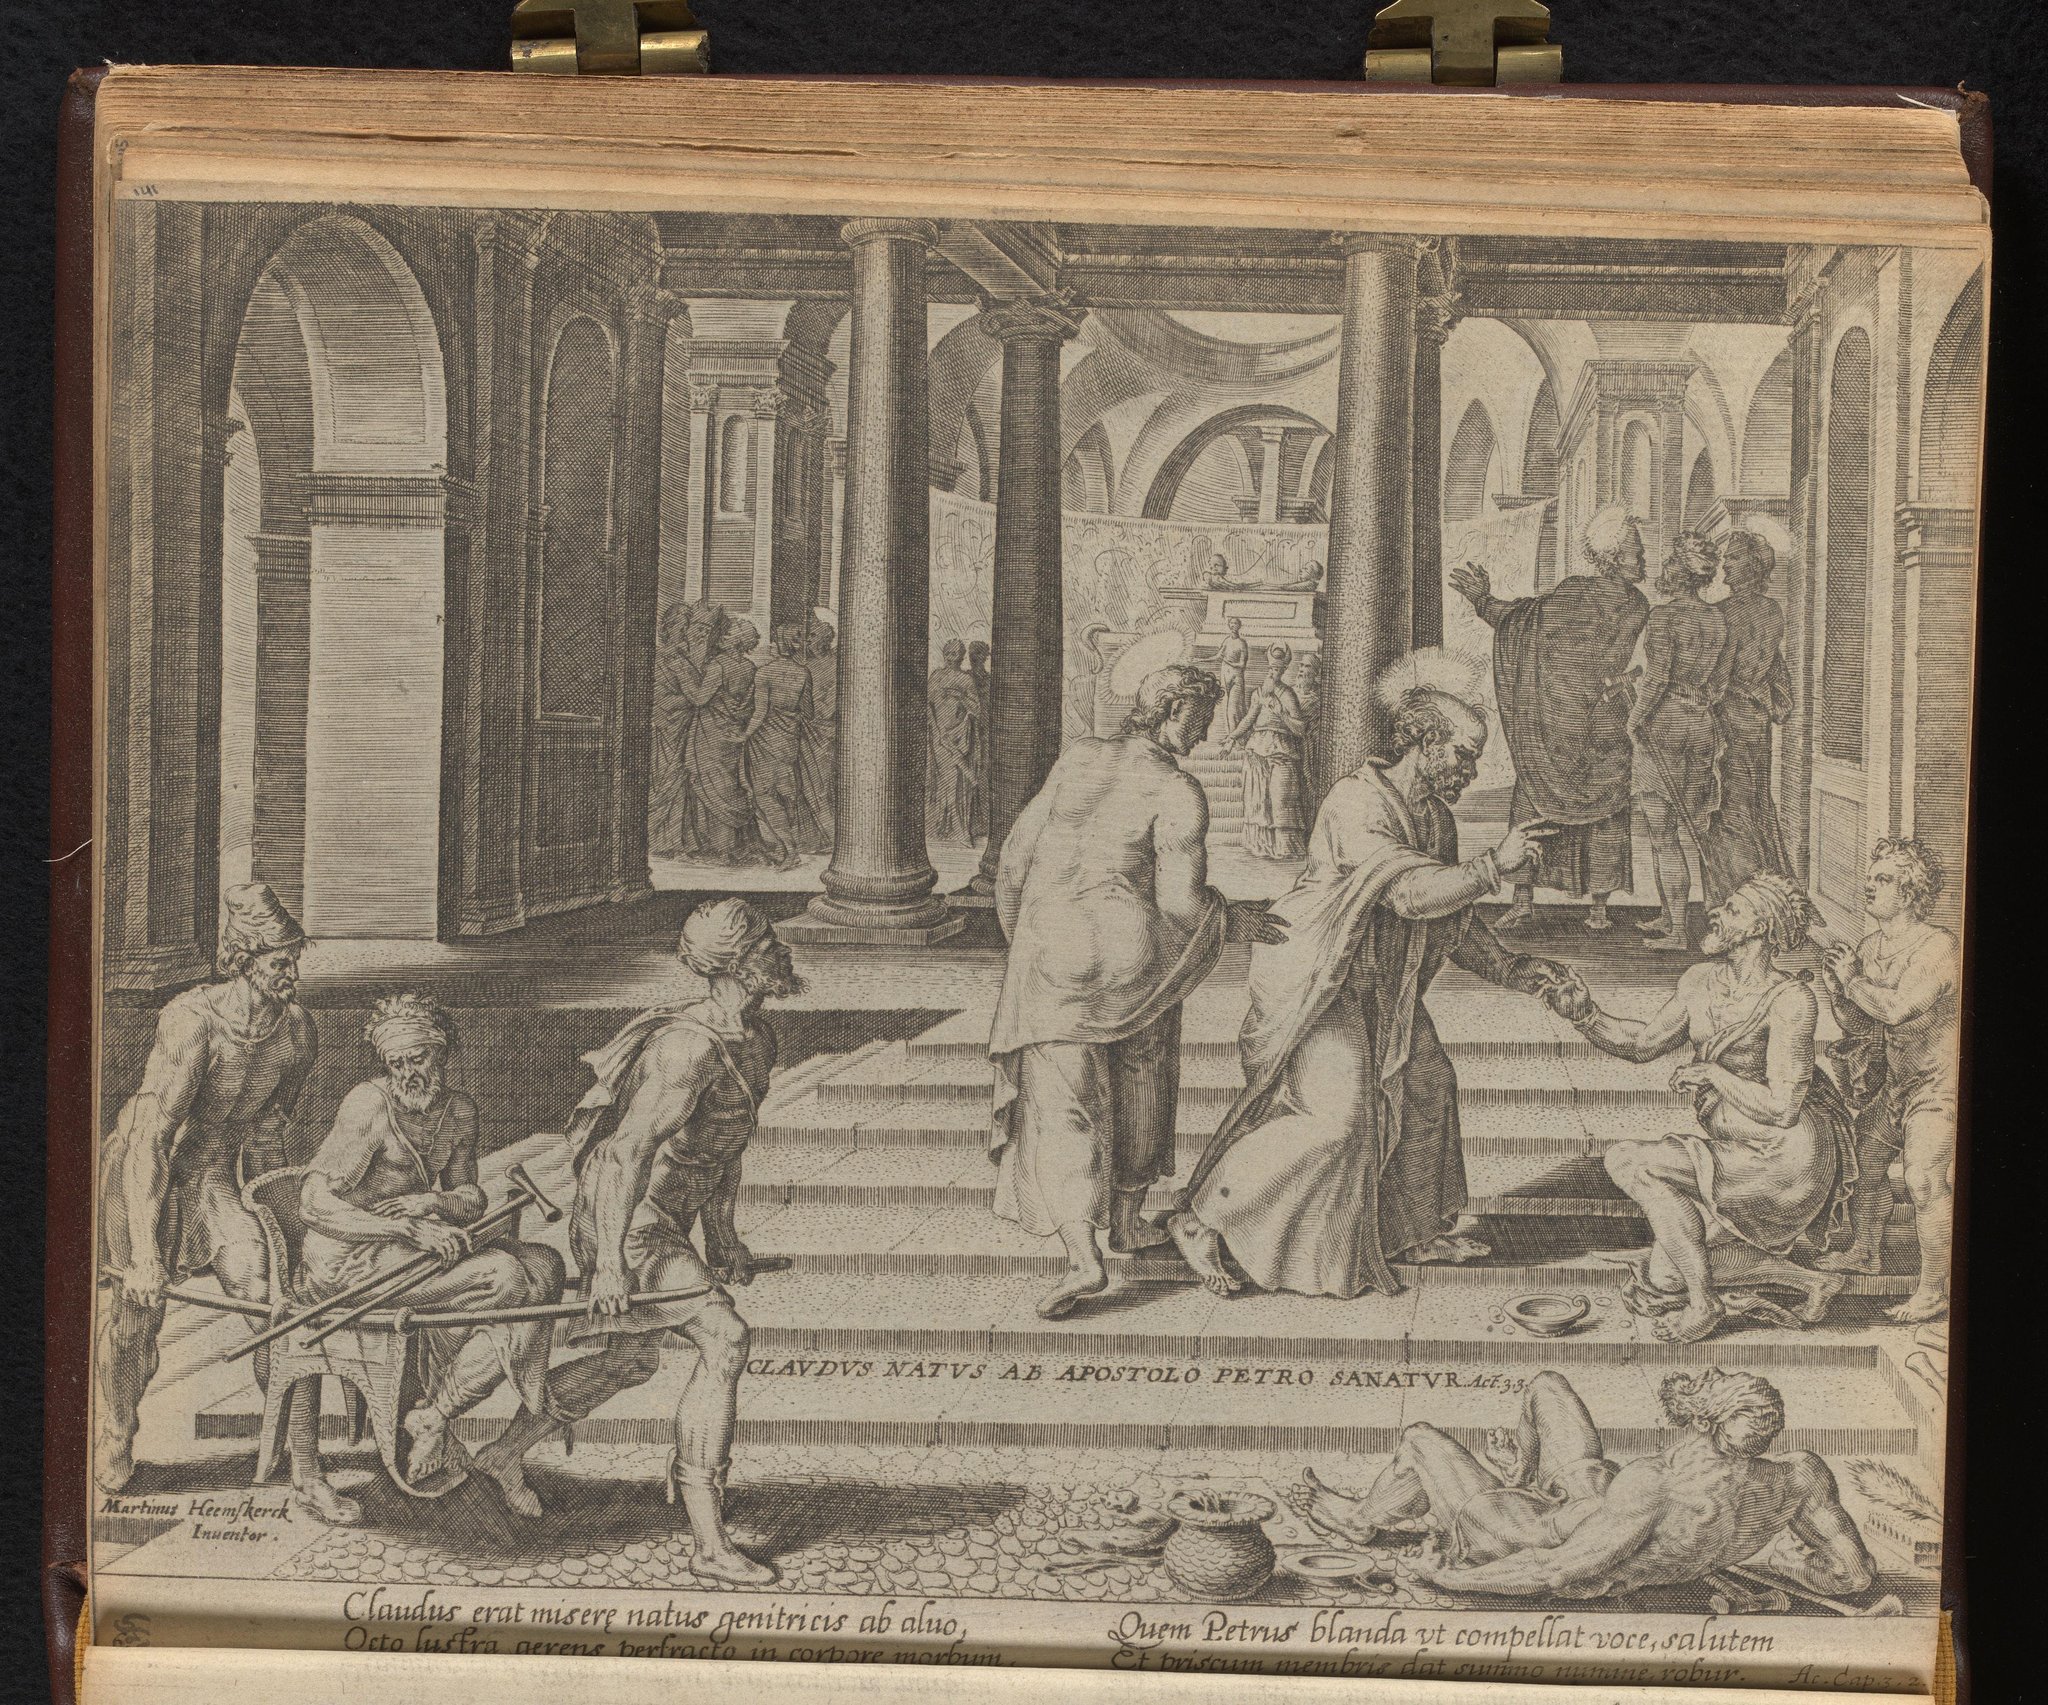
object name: album leaf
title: Acta Apostolorum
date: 1575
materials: paper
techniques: engraving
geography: antwerp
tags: healing of a lame beggar at the beautiful gate of the temple by peter and john (acts 3 - 4:31)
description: Prent maakt deel uit van een prentbijbel.